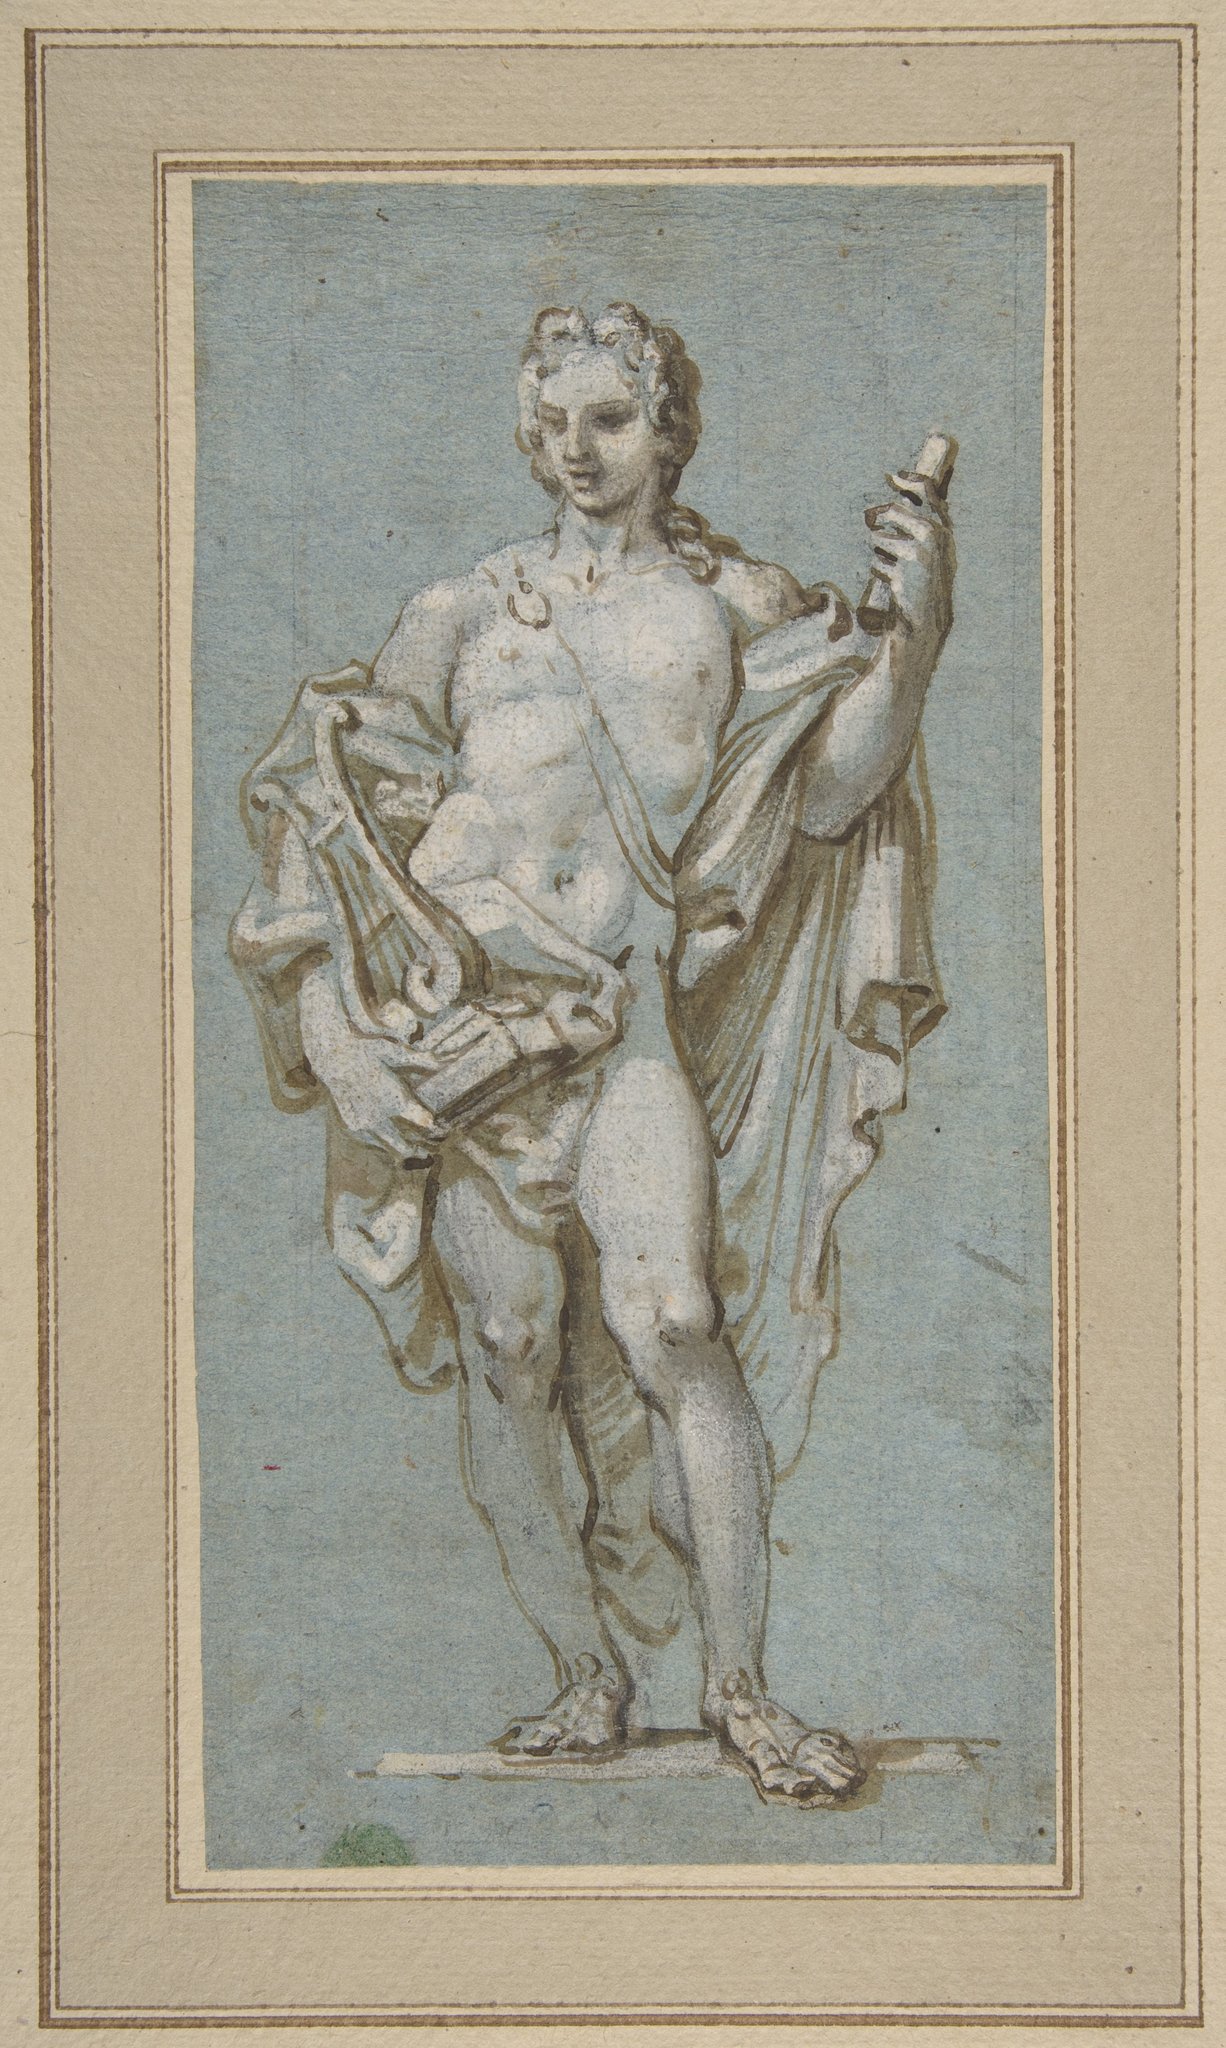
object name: drawing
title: Standing Figure of Apollo with a Lyre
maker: paolo gerolamo piola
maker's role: artist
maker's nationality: italian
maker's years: 1666-1724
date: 1666-1724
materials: charcoal, paper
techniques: brush, highlighting, wash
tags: musical instruments,apollo